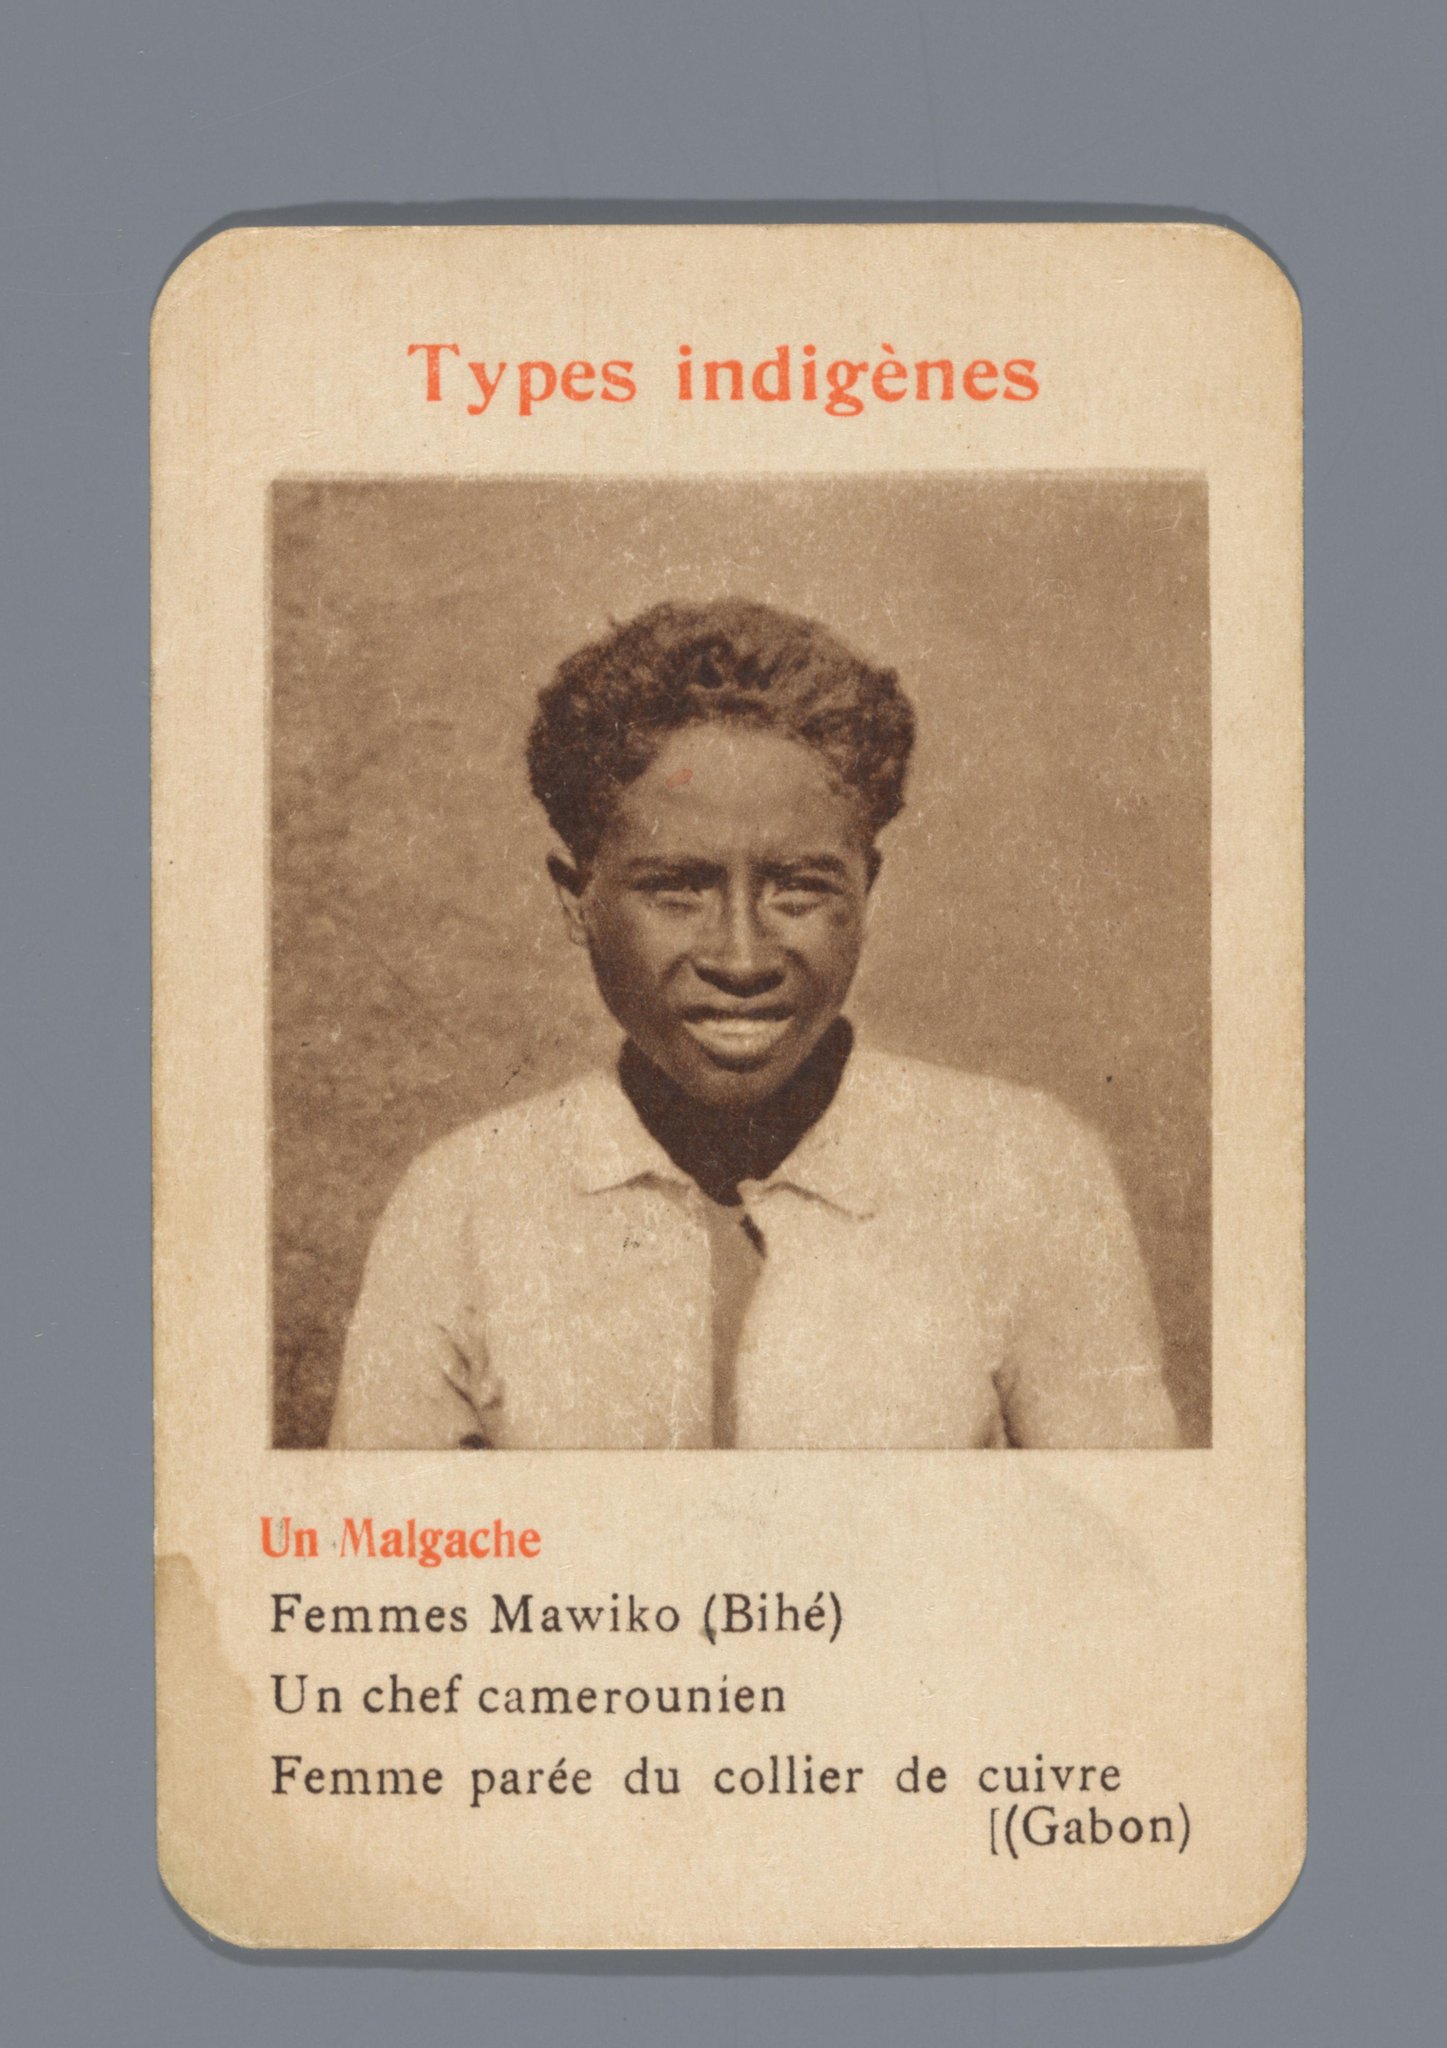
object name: photomechanical print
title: Types indigènes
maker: Anonymous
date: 1900-1920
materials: cardboard, paper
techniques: rotogravure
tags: africans, historical persons, card games